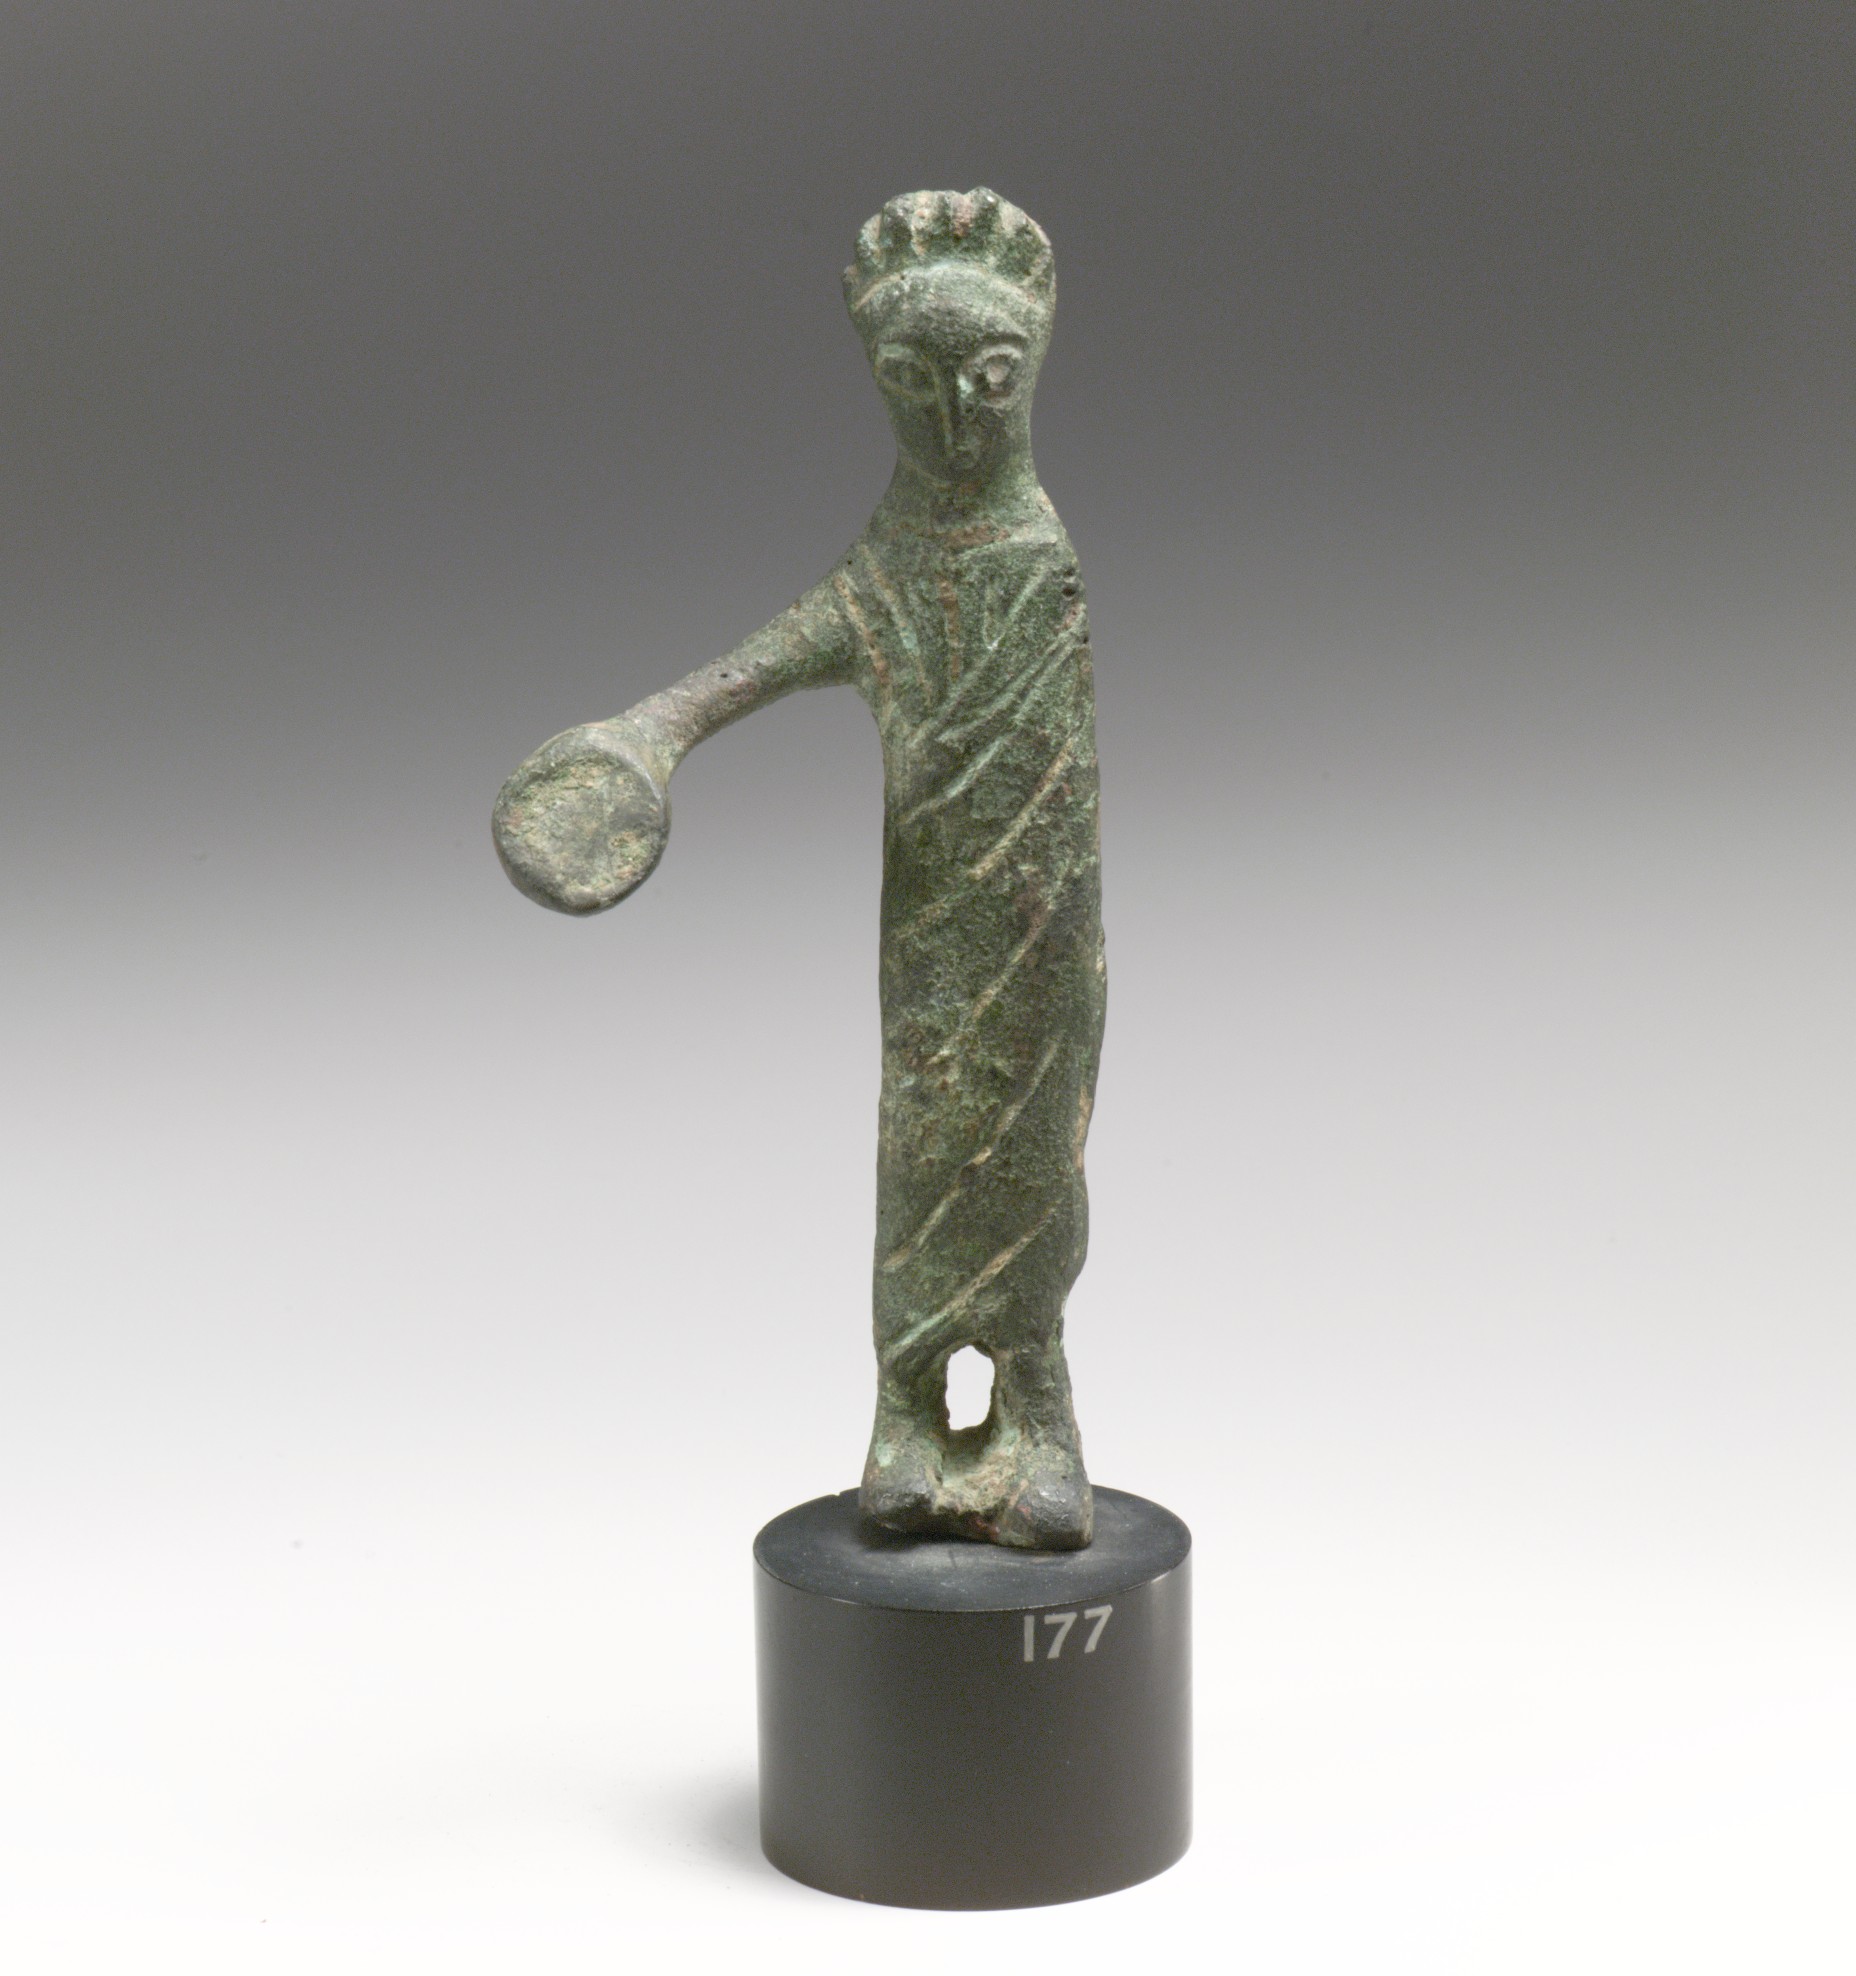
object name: statuette of a woman or goddess with phiale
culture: etruscan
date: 300-1 BCE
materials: bronze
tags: women